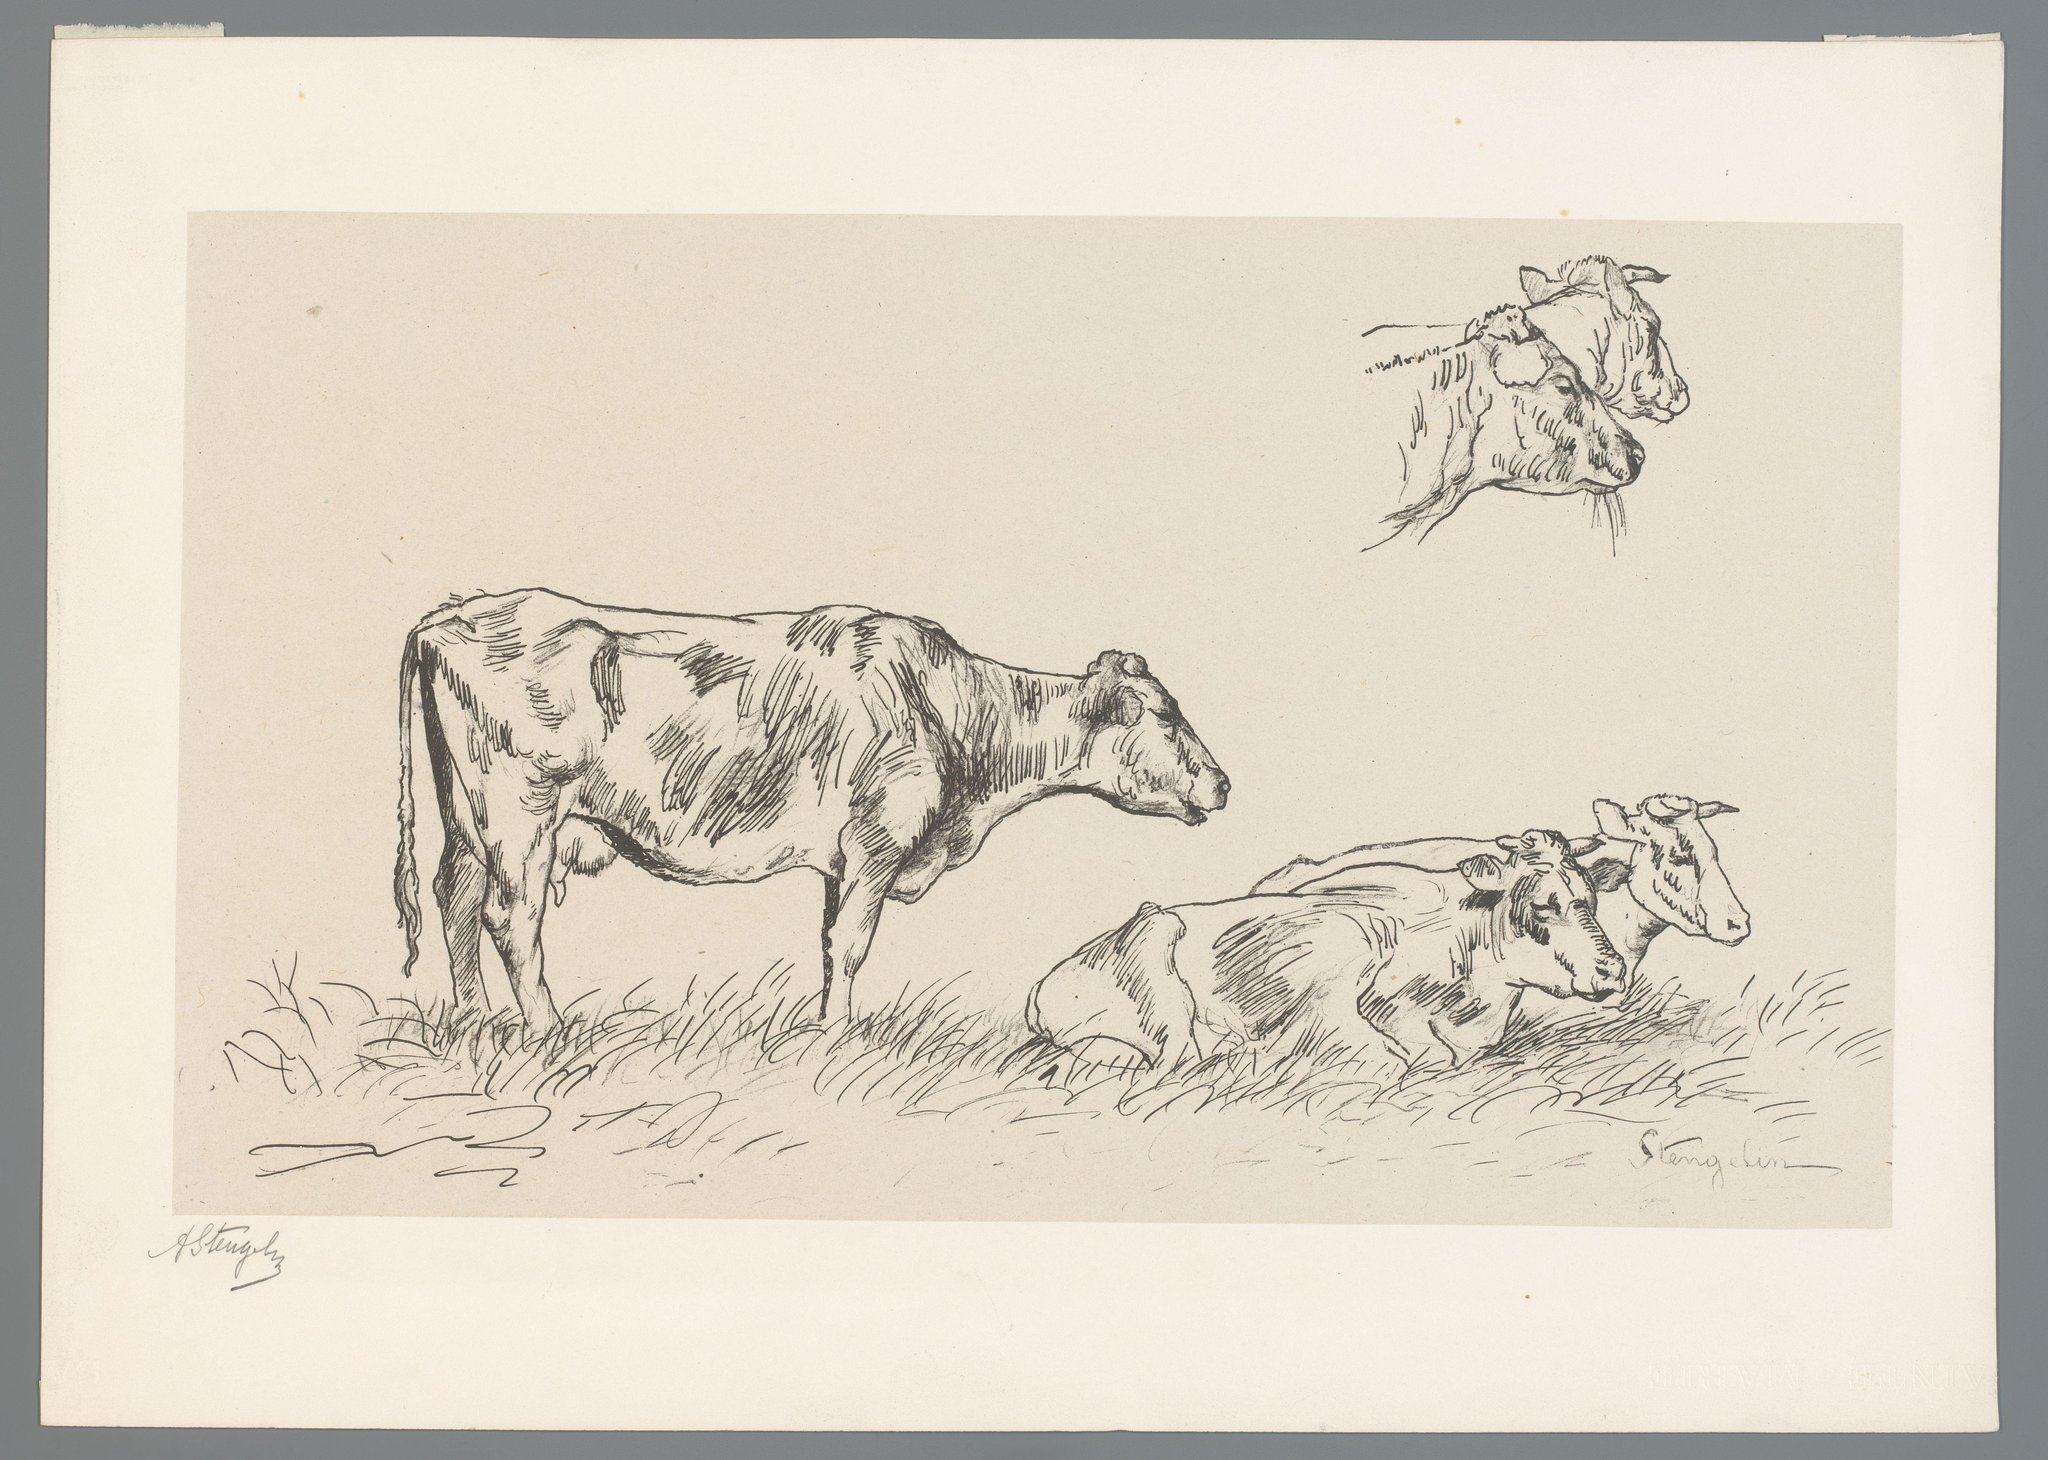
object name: print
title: Étude de vaches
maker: alphonse stengelin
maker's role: painter, print maker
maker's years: 1852-1938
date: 1876-1910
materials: paper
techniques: lithograph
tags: cow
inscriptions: collector's mark: Lugt 2228